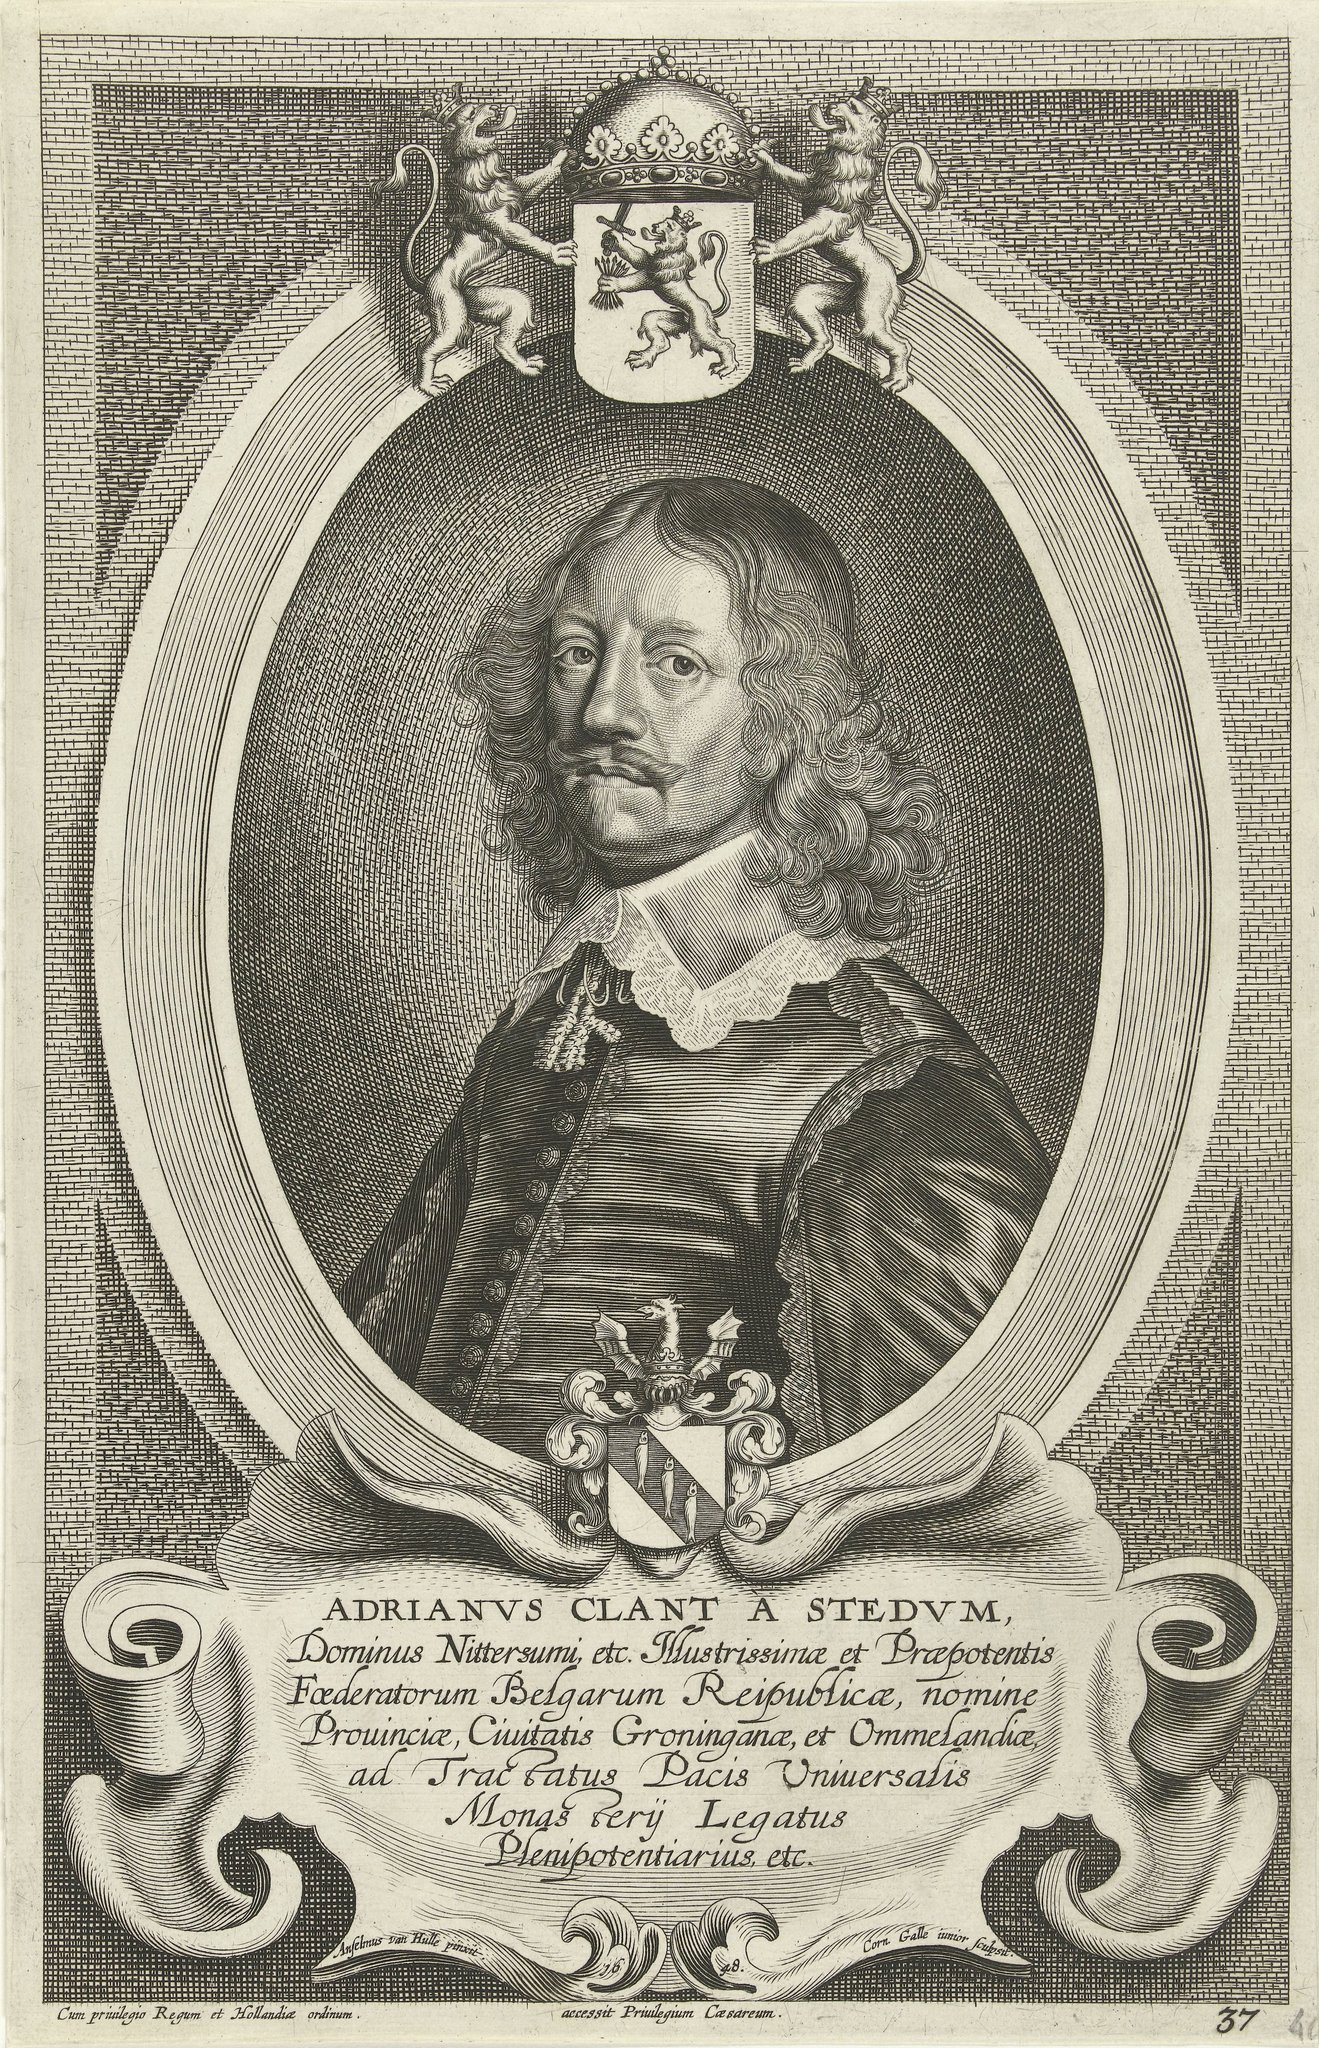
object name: print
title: Celeberrimi ad pacificandum Christiani nominis orbem legati Monasterium et Osnabrugas (...)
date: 1648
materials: paper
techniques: engraving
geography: antwerp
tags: diplomaat, adriaen clant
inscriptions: collector's mark: Lugt 2228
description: Portret van Adriaan Clant tot Stedum, afgevaardigde voor Groningen bij de onderhandelingen voor de Vrede van Münster, in ovaal met familiewapens.